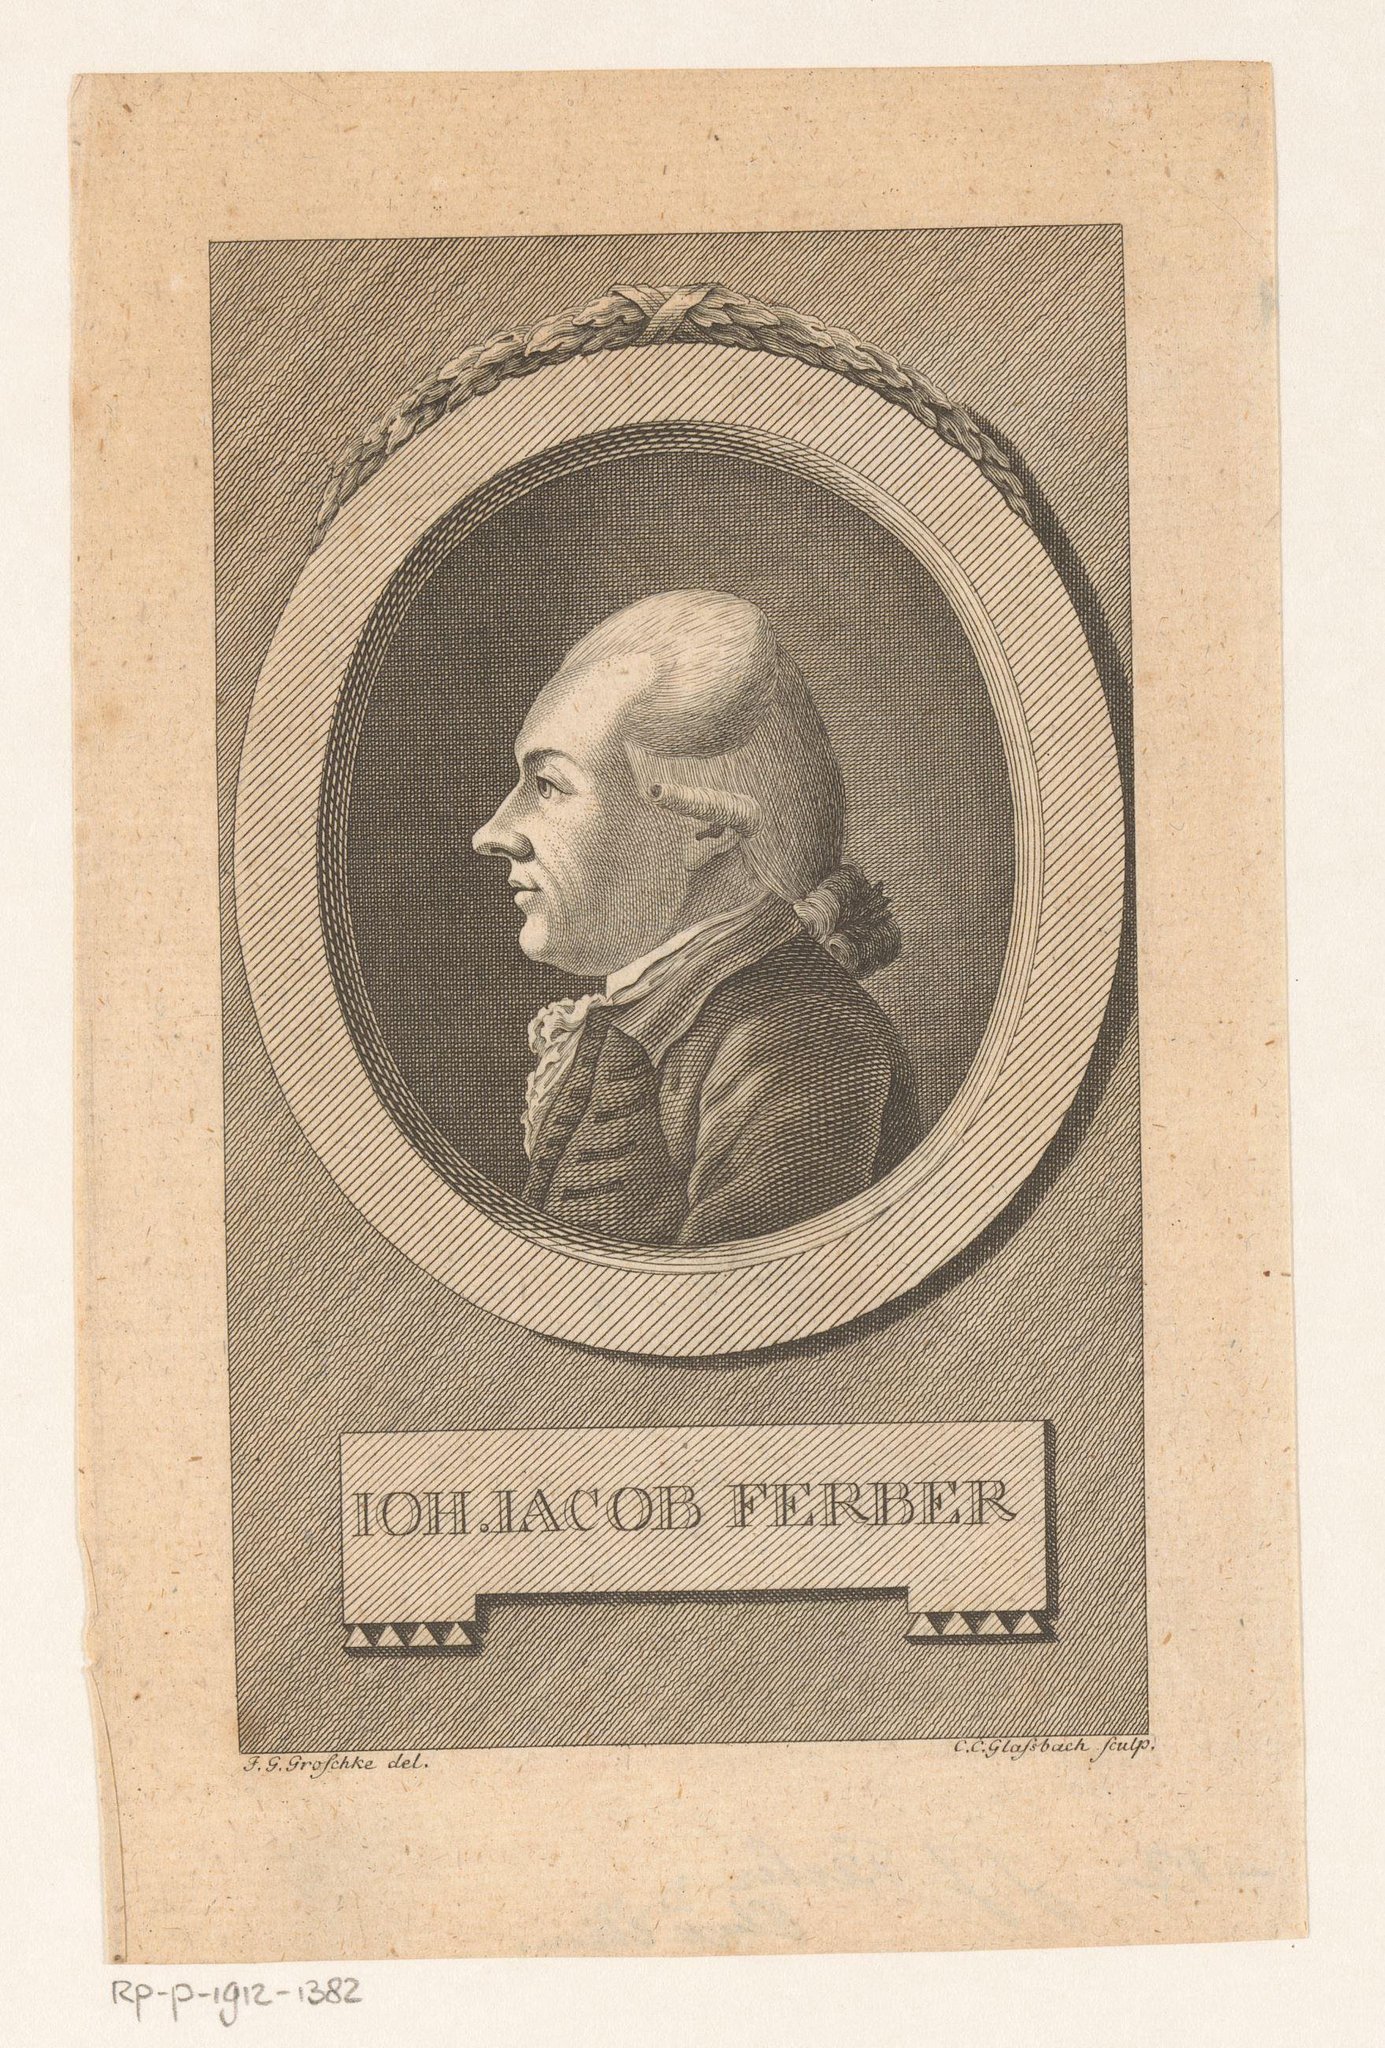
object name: print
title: Portret van Johann Jacob Ferber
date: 1761-1789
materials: paper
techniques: engraving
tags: historical persons, ornament ~ festoon, garland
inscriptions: collector's mark: Lugt 2228